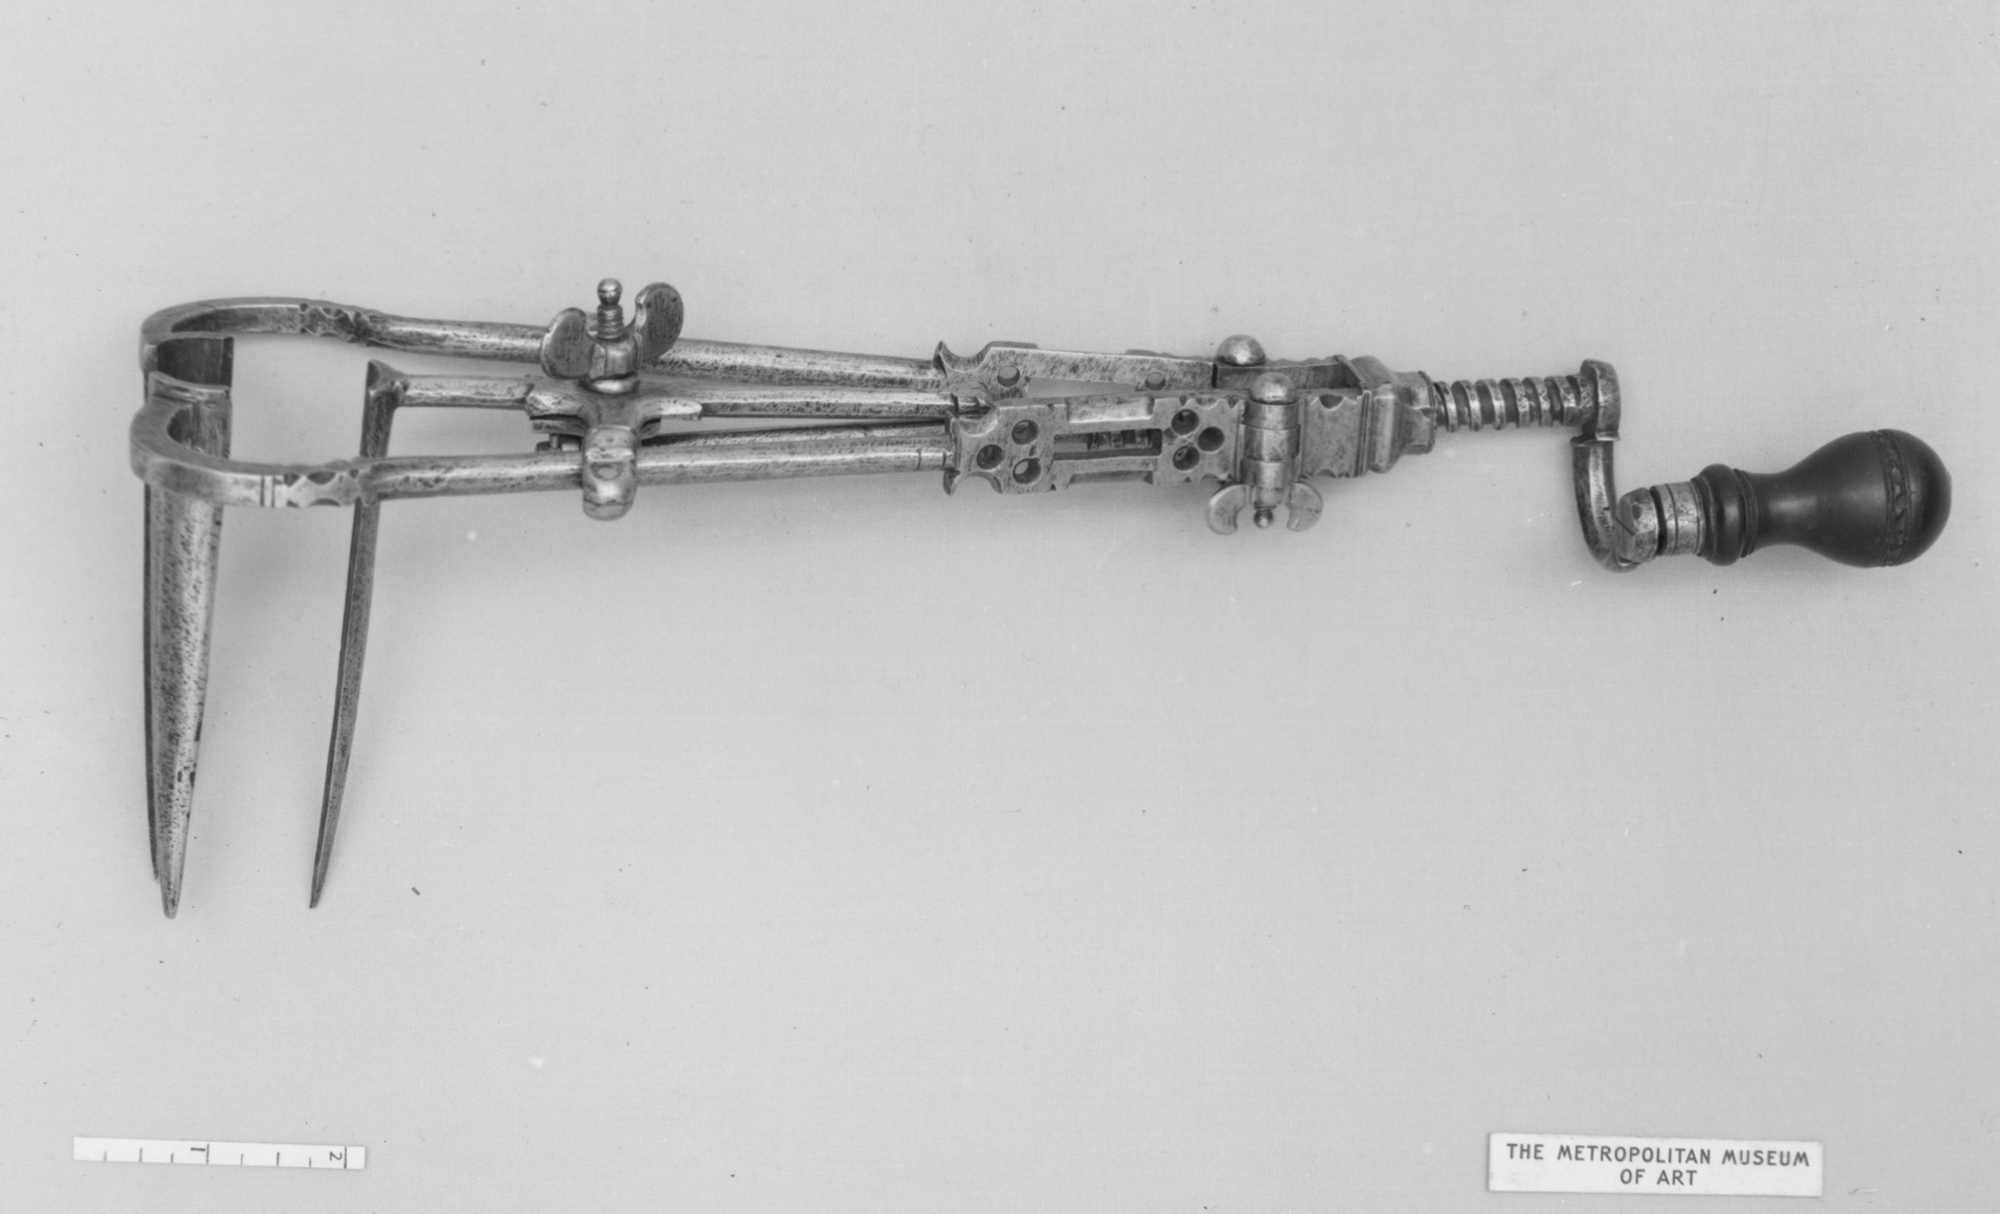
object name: vaginal dilator and speculum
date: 1601-1700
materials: steel